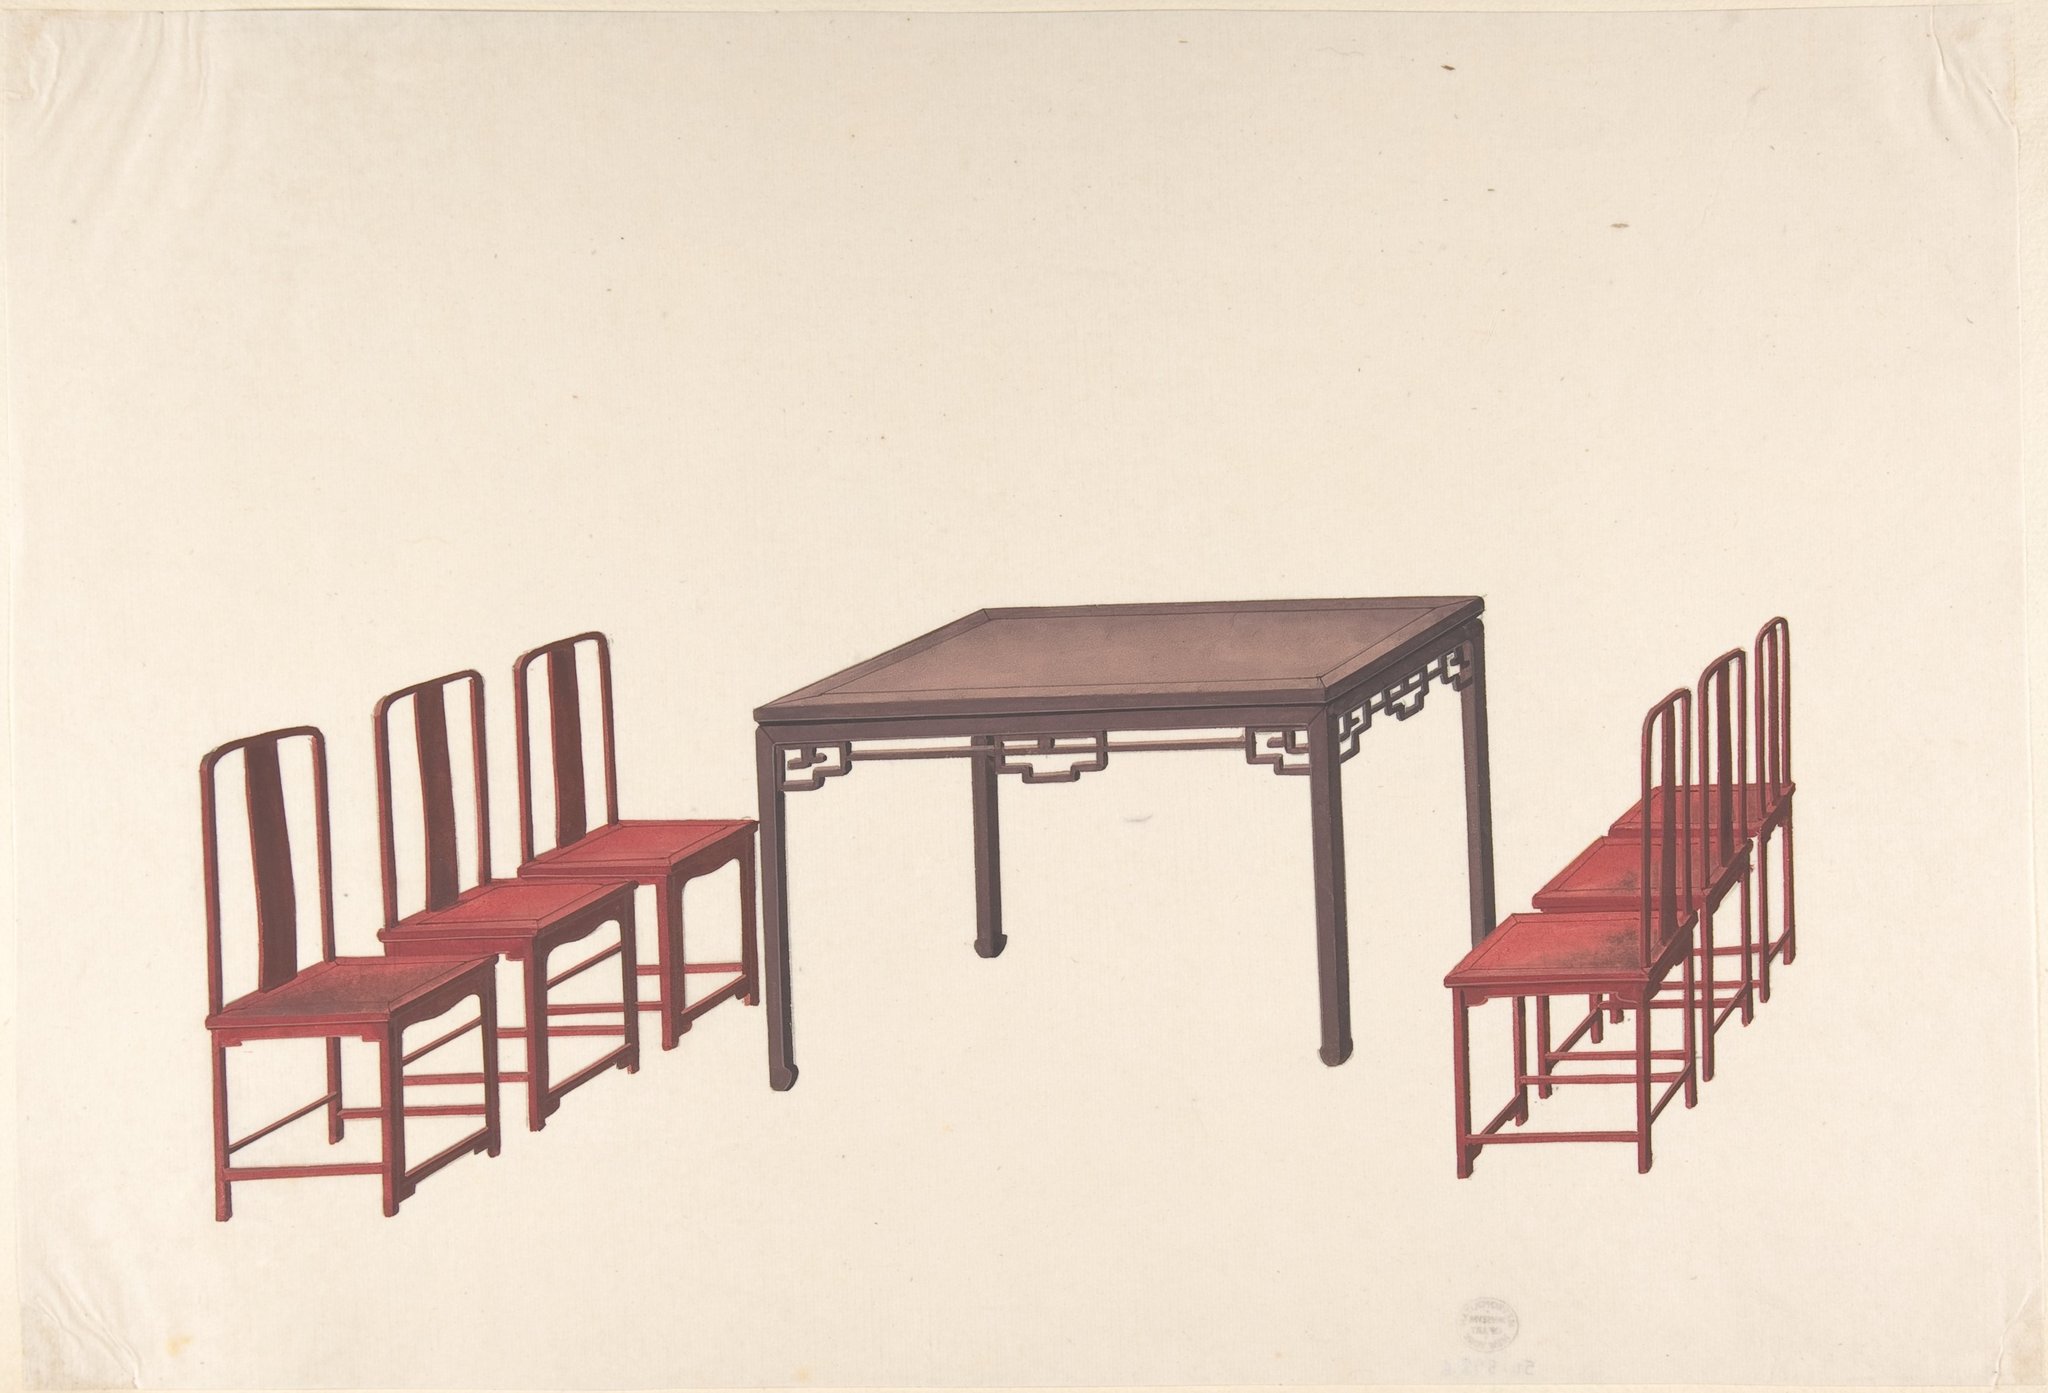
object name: drawing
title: Design for Export Furniture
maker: anonymous, chinese, 19th century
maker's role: artist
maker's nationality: chinese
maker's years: 1800-1900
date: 1800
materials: graphite, watercolor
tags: chairs,tables